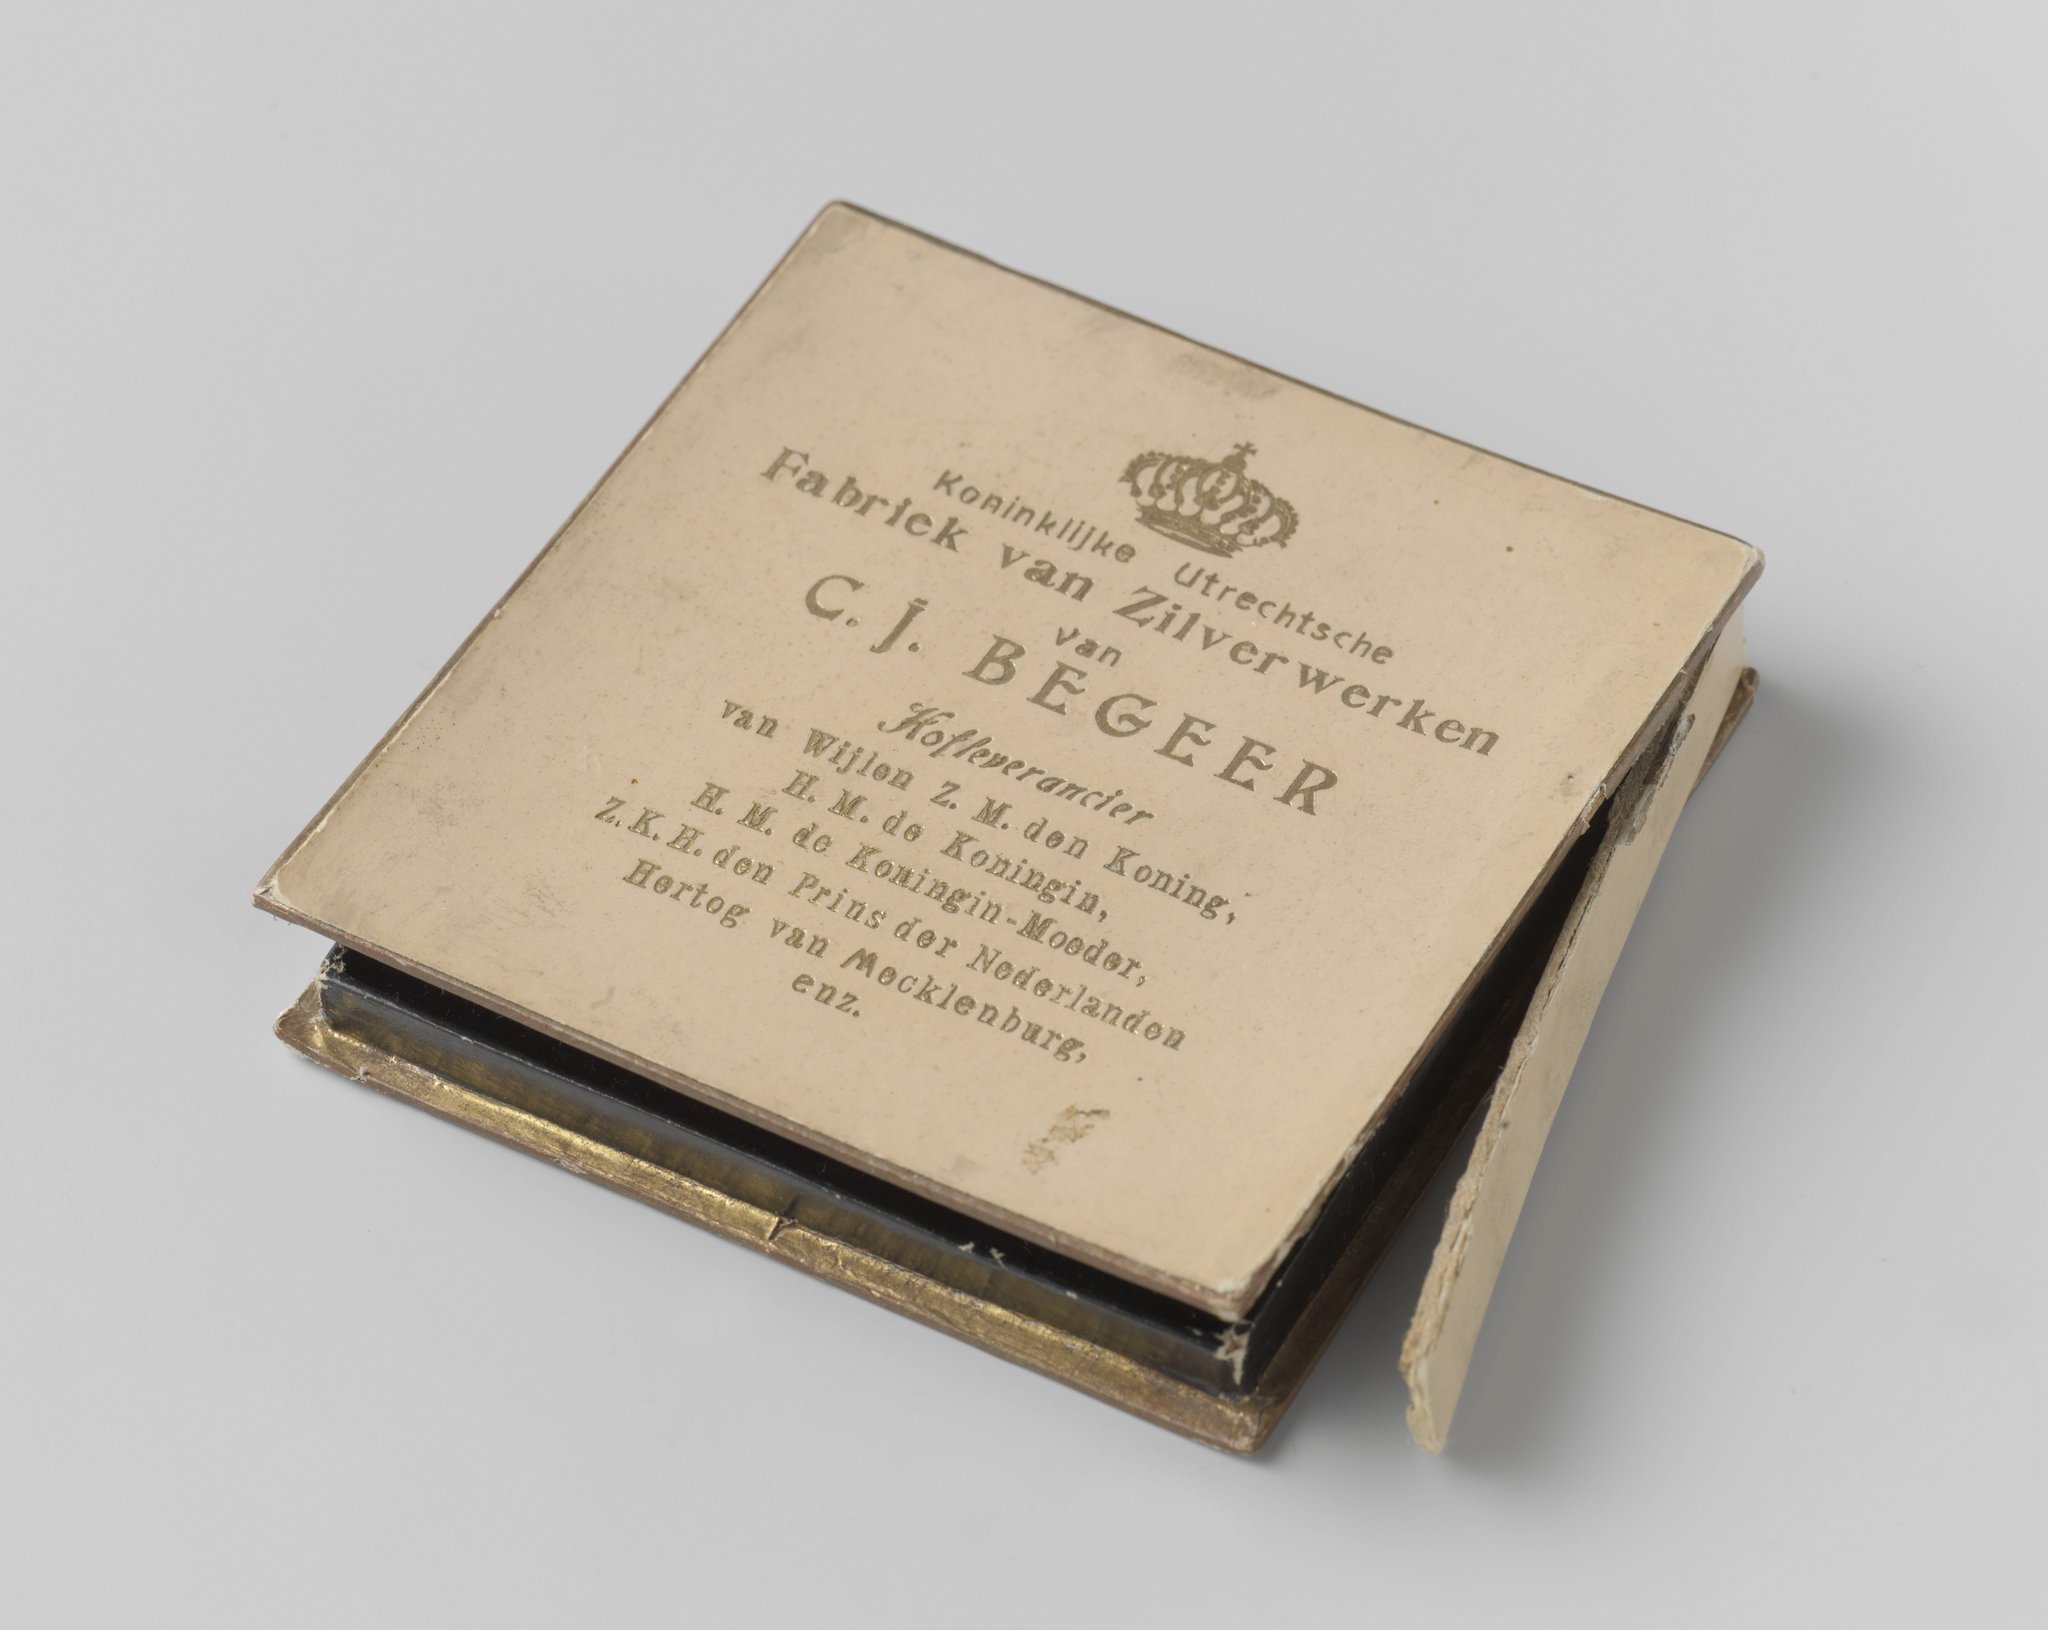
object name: medal box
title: Doosje voor de penning ter ere van het derde eeuwfeest van Rembrandts geboorte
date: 1906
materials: cardboard, velvet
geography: utrecht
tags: leiden, amsterdam, painter, print maker, draughtsman, rembrandt van rijn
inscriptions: inscription: ‘Koninklijke Utrechtsche / Fabriek van Zilverwerken / van / C.J. BEGEER / Hofleverancier / van Wijlen Z. M. den Koning, / H.M. de Koningin, / H.M. de Koningin-Moeder, / ZK.H. den Prins der Nederlanden / Hertog van Mecklenburg, / enz.’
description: Beige kartonnen doosje (losse deksel en bodem) voor de penning ter ere van het derde eeuwfeest van Rembrandts geboorte (NG-1992-10-A). Op bovenzijde van het deksel in goud druksel een kroon met daaronder in goudletters opschrift. Kussentje van textiel aan binnenzijde deksel. De bak is van binnen bedekt met donkerblauw fluweel en heeft een ronde uitsparing voor de penning. Het heeft een goudkleurige rand en witte onderzijde.